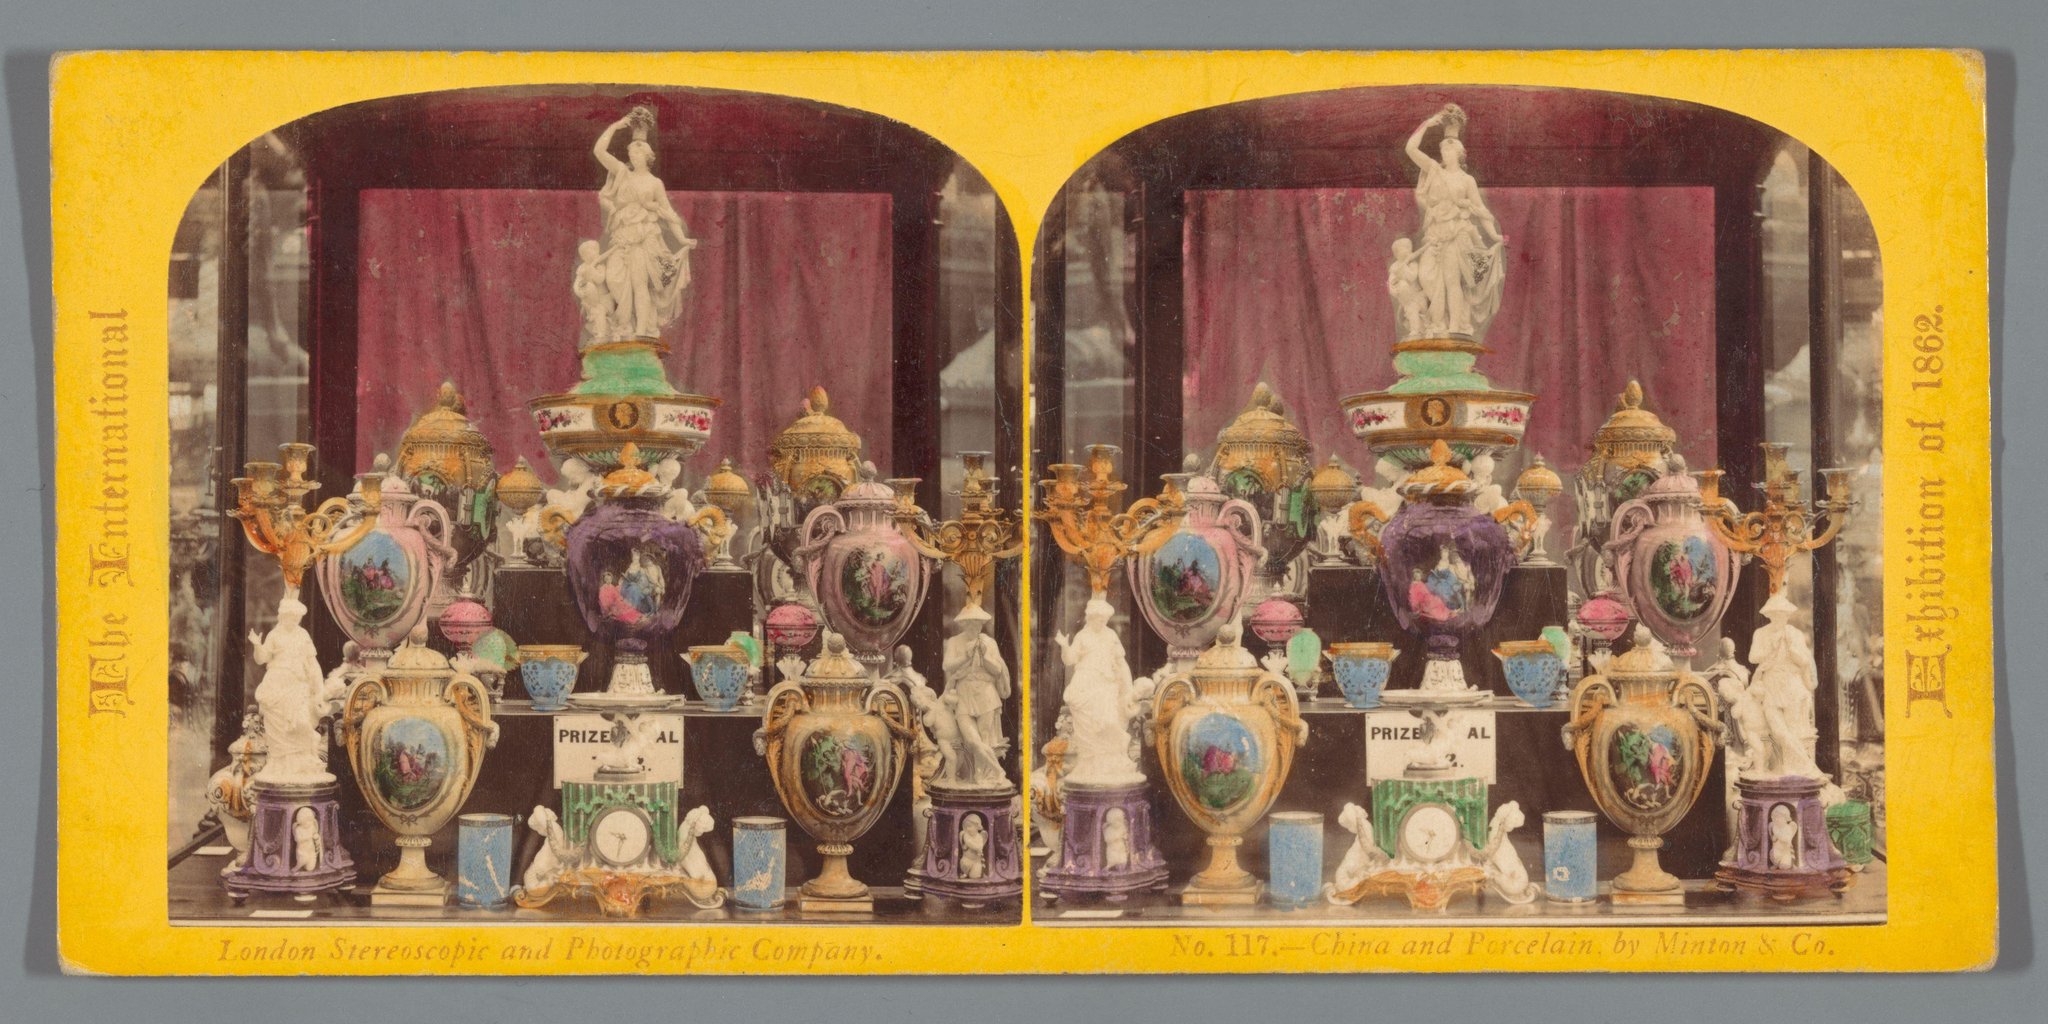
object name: stereograph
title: Afdeling Chinees porselein van Minton & Co op de Wereldtentoonstelling van 1862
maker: william england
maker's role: fotograaf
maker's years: 1816-1896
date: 1862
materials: cardboard, paper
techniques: albumen print, hand coloring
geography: london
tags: world fair, world exhibition, container of ceramics: jar, jug, pot, vase, london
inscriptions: inscription: ‘1’, inscription: ‘[...]/ A:2’, number: ‘No. 117.’